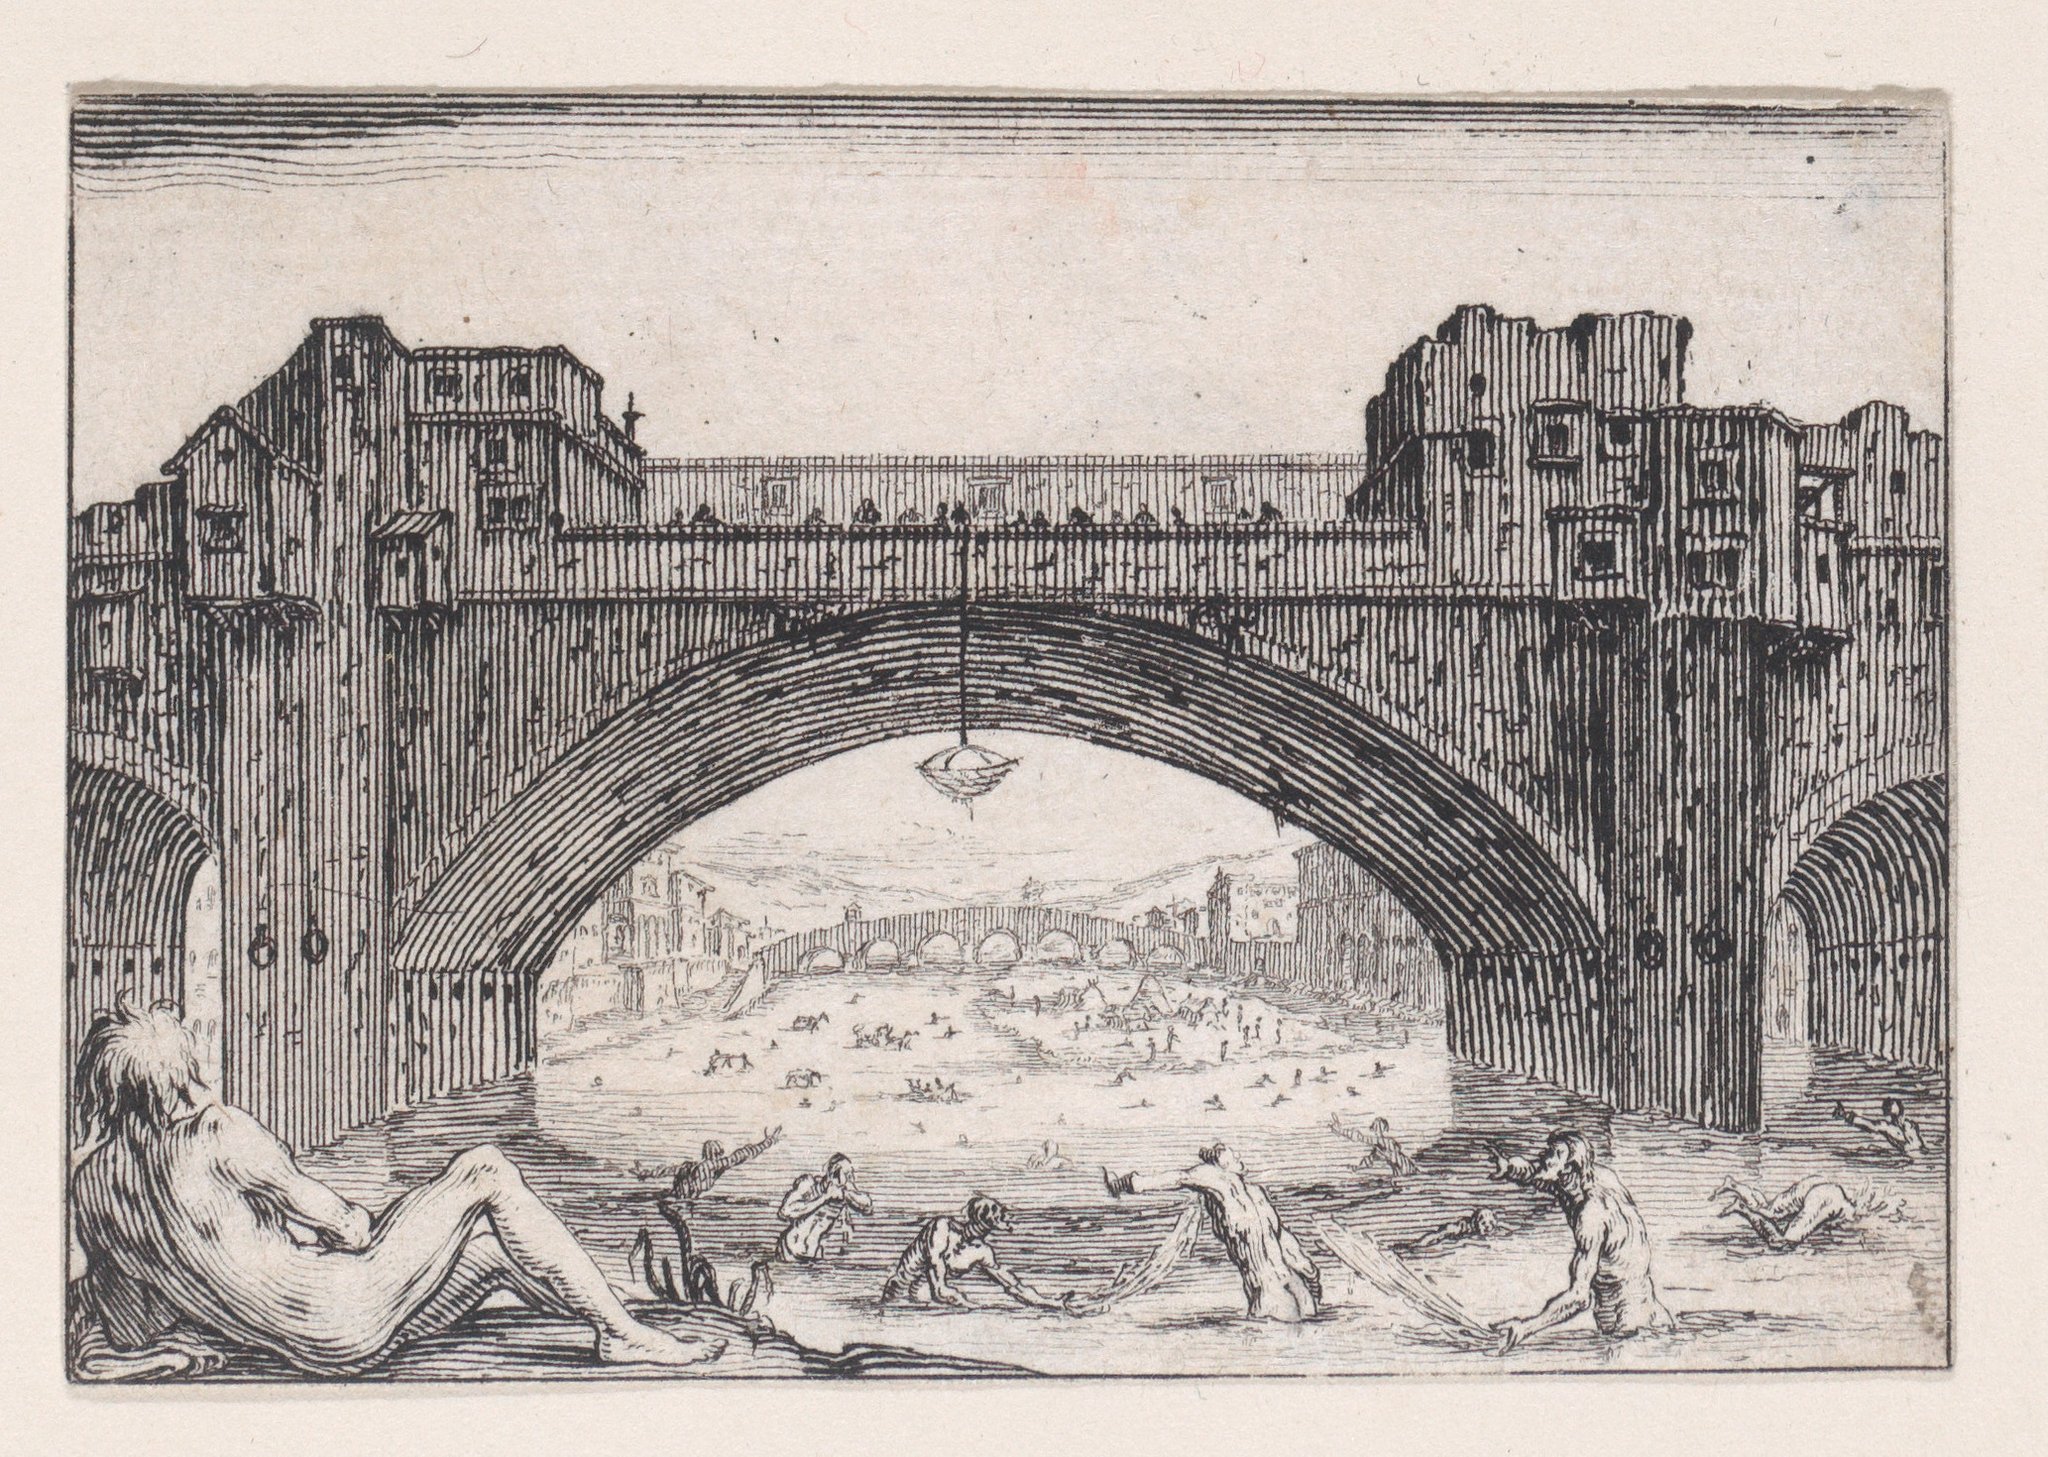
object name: print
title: Le Ponte-Vecchio, a Florence (The Ponte-Vecchio in Florence), from "Les Caprices" Series A, The Florence Set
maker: jacques callot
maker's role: artist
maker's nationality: french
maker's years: 1592-1635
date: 1617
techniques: etching